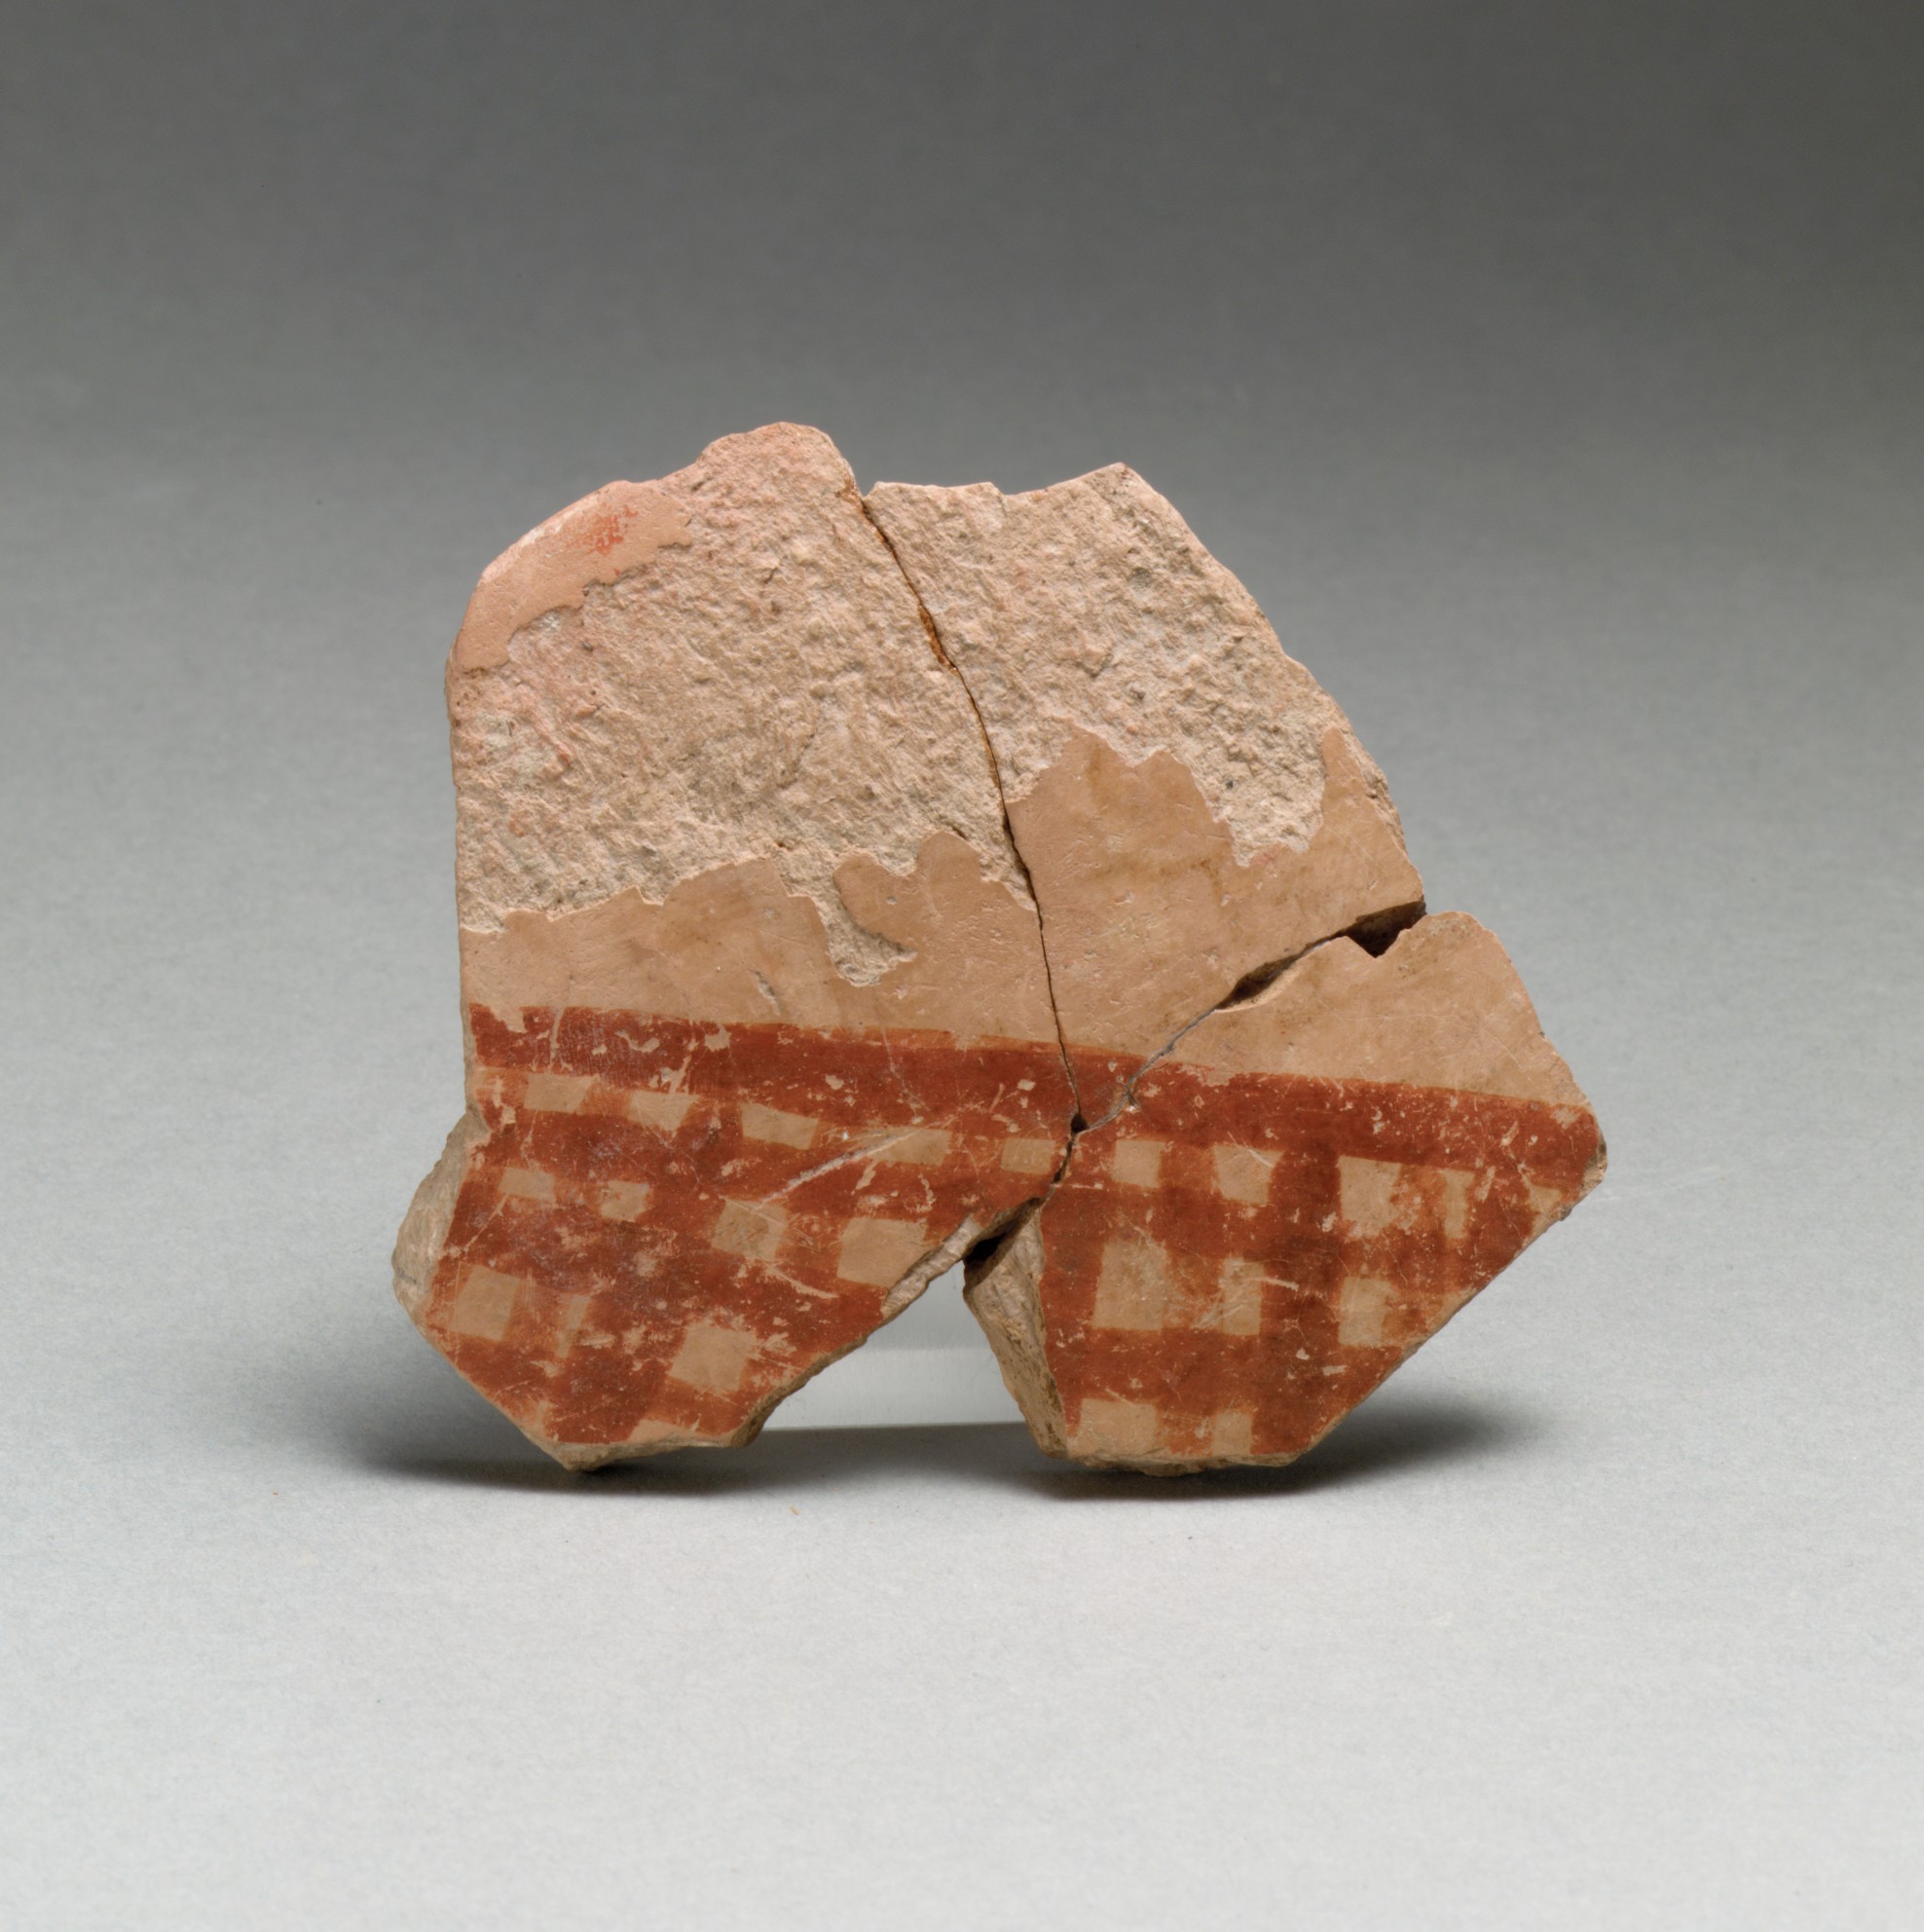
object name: vase fragment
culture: neolithic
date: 4000 BCE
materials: terracotta